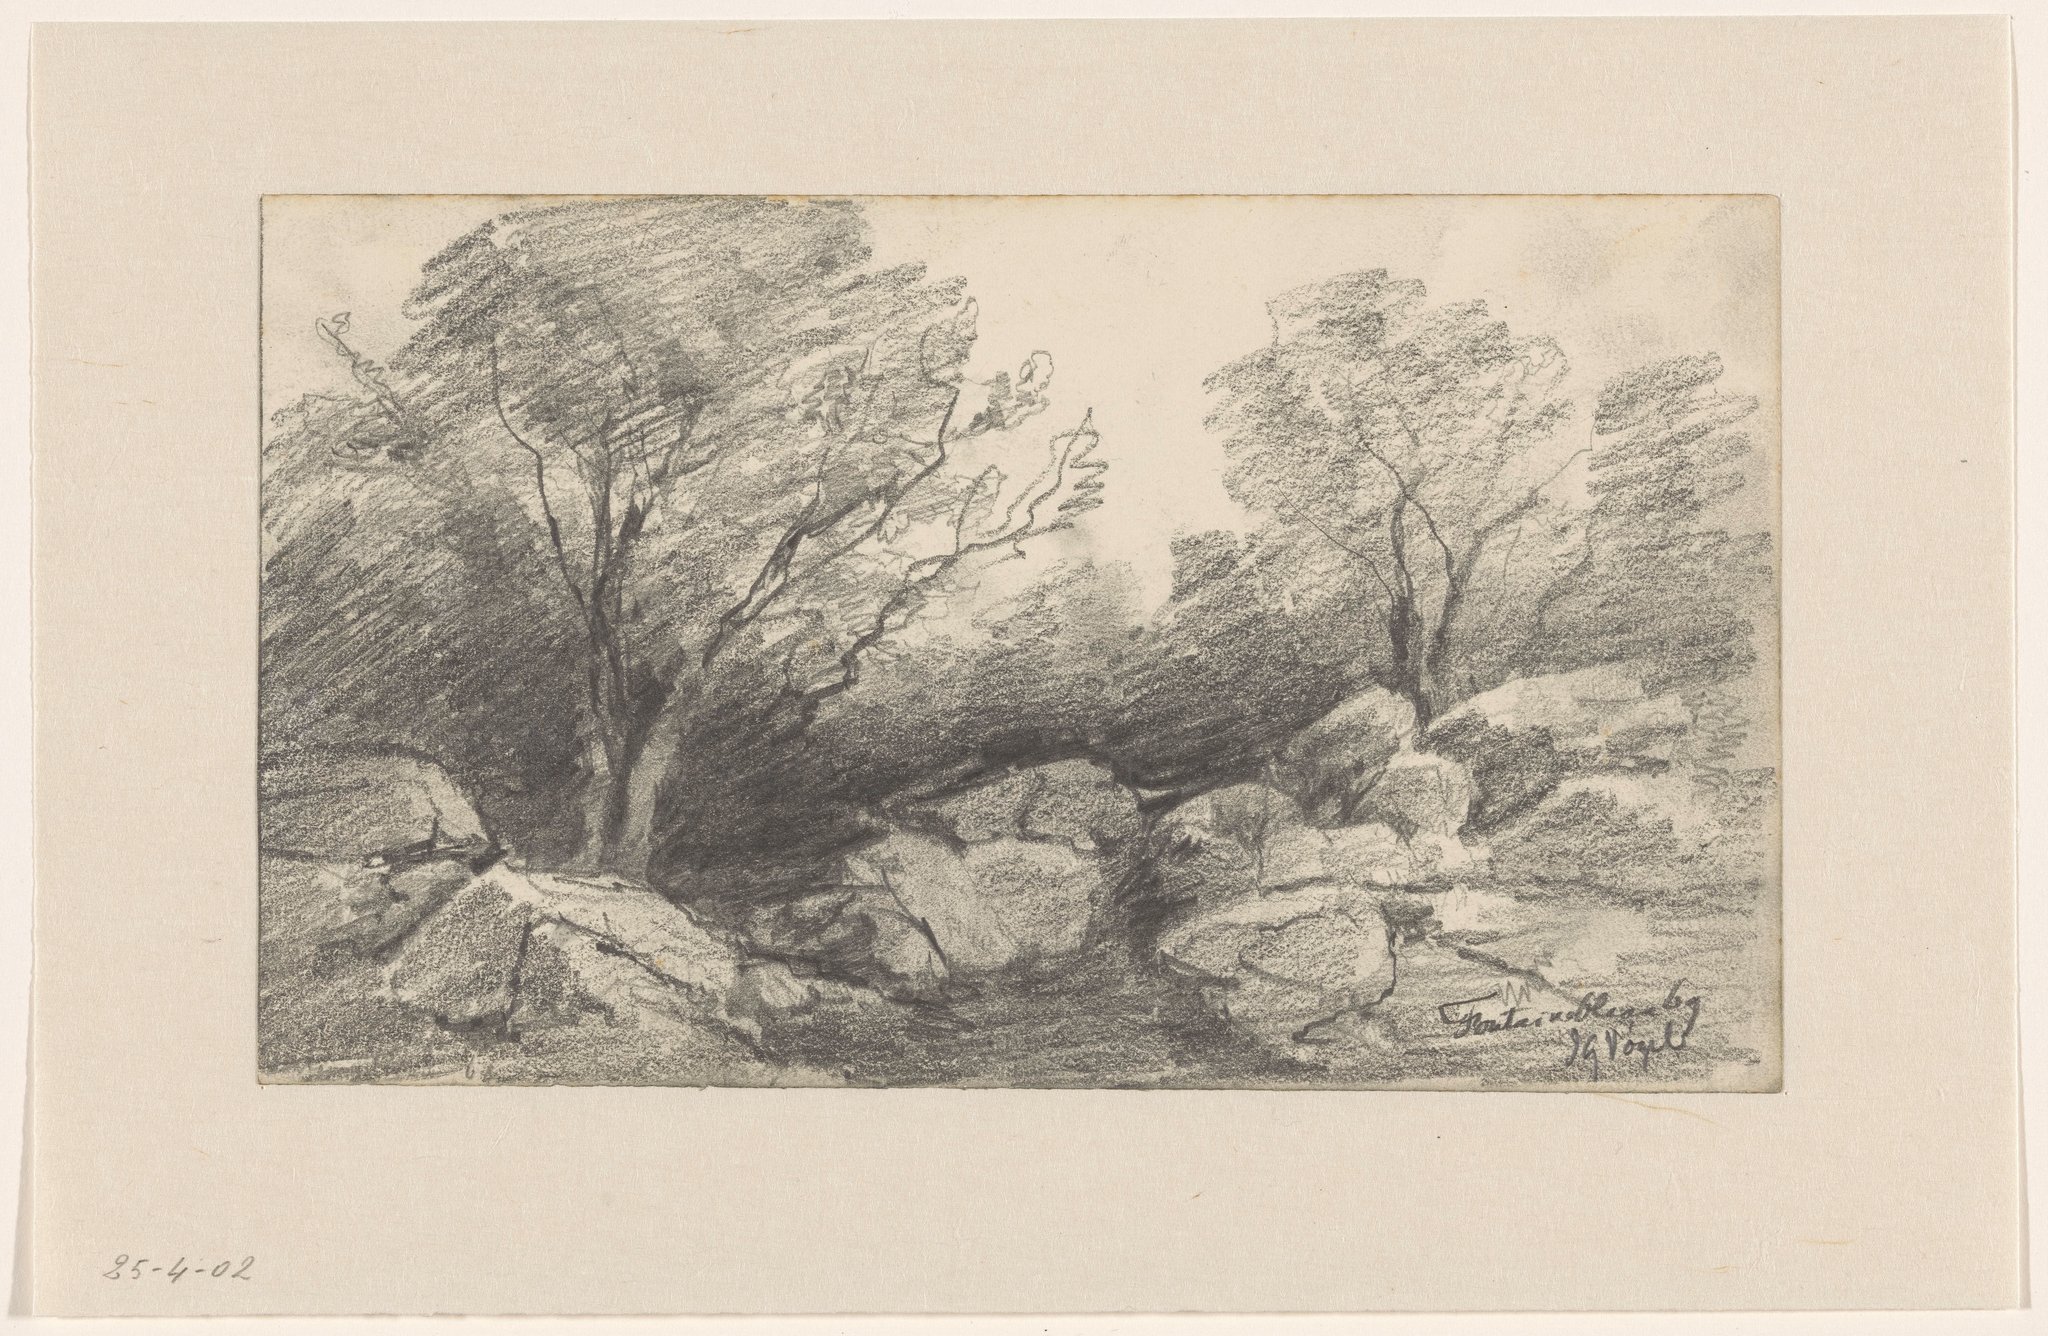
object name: drawing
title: Rotsachtig landschap met bomen, Fontainebleau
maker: johannes gijsbert vogel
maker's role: draughtsman, painter, print maker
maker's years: 1828-1915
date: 1869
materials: chalk, paper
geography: fontainebleau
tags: forest, wood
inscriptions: date